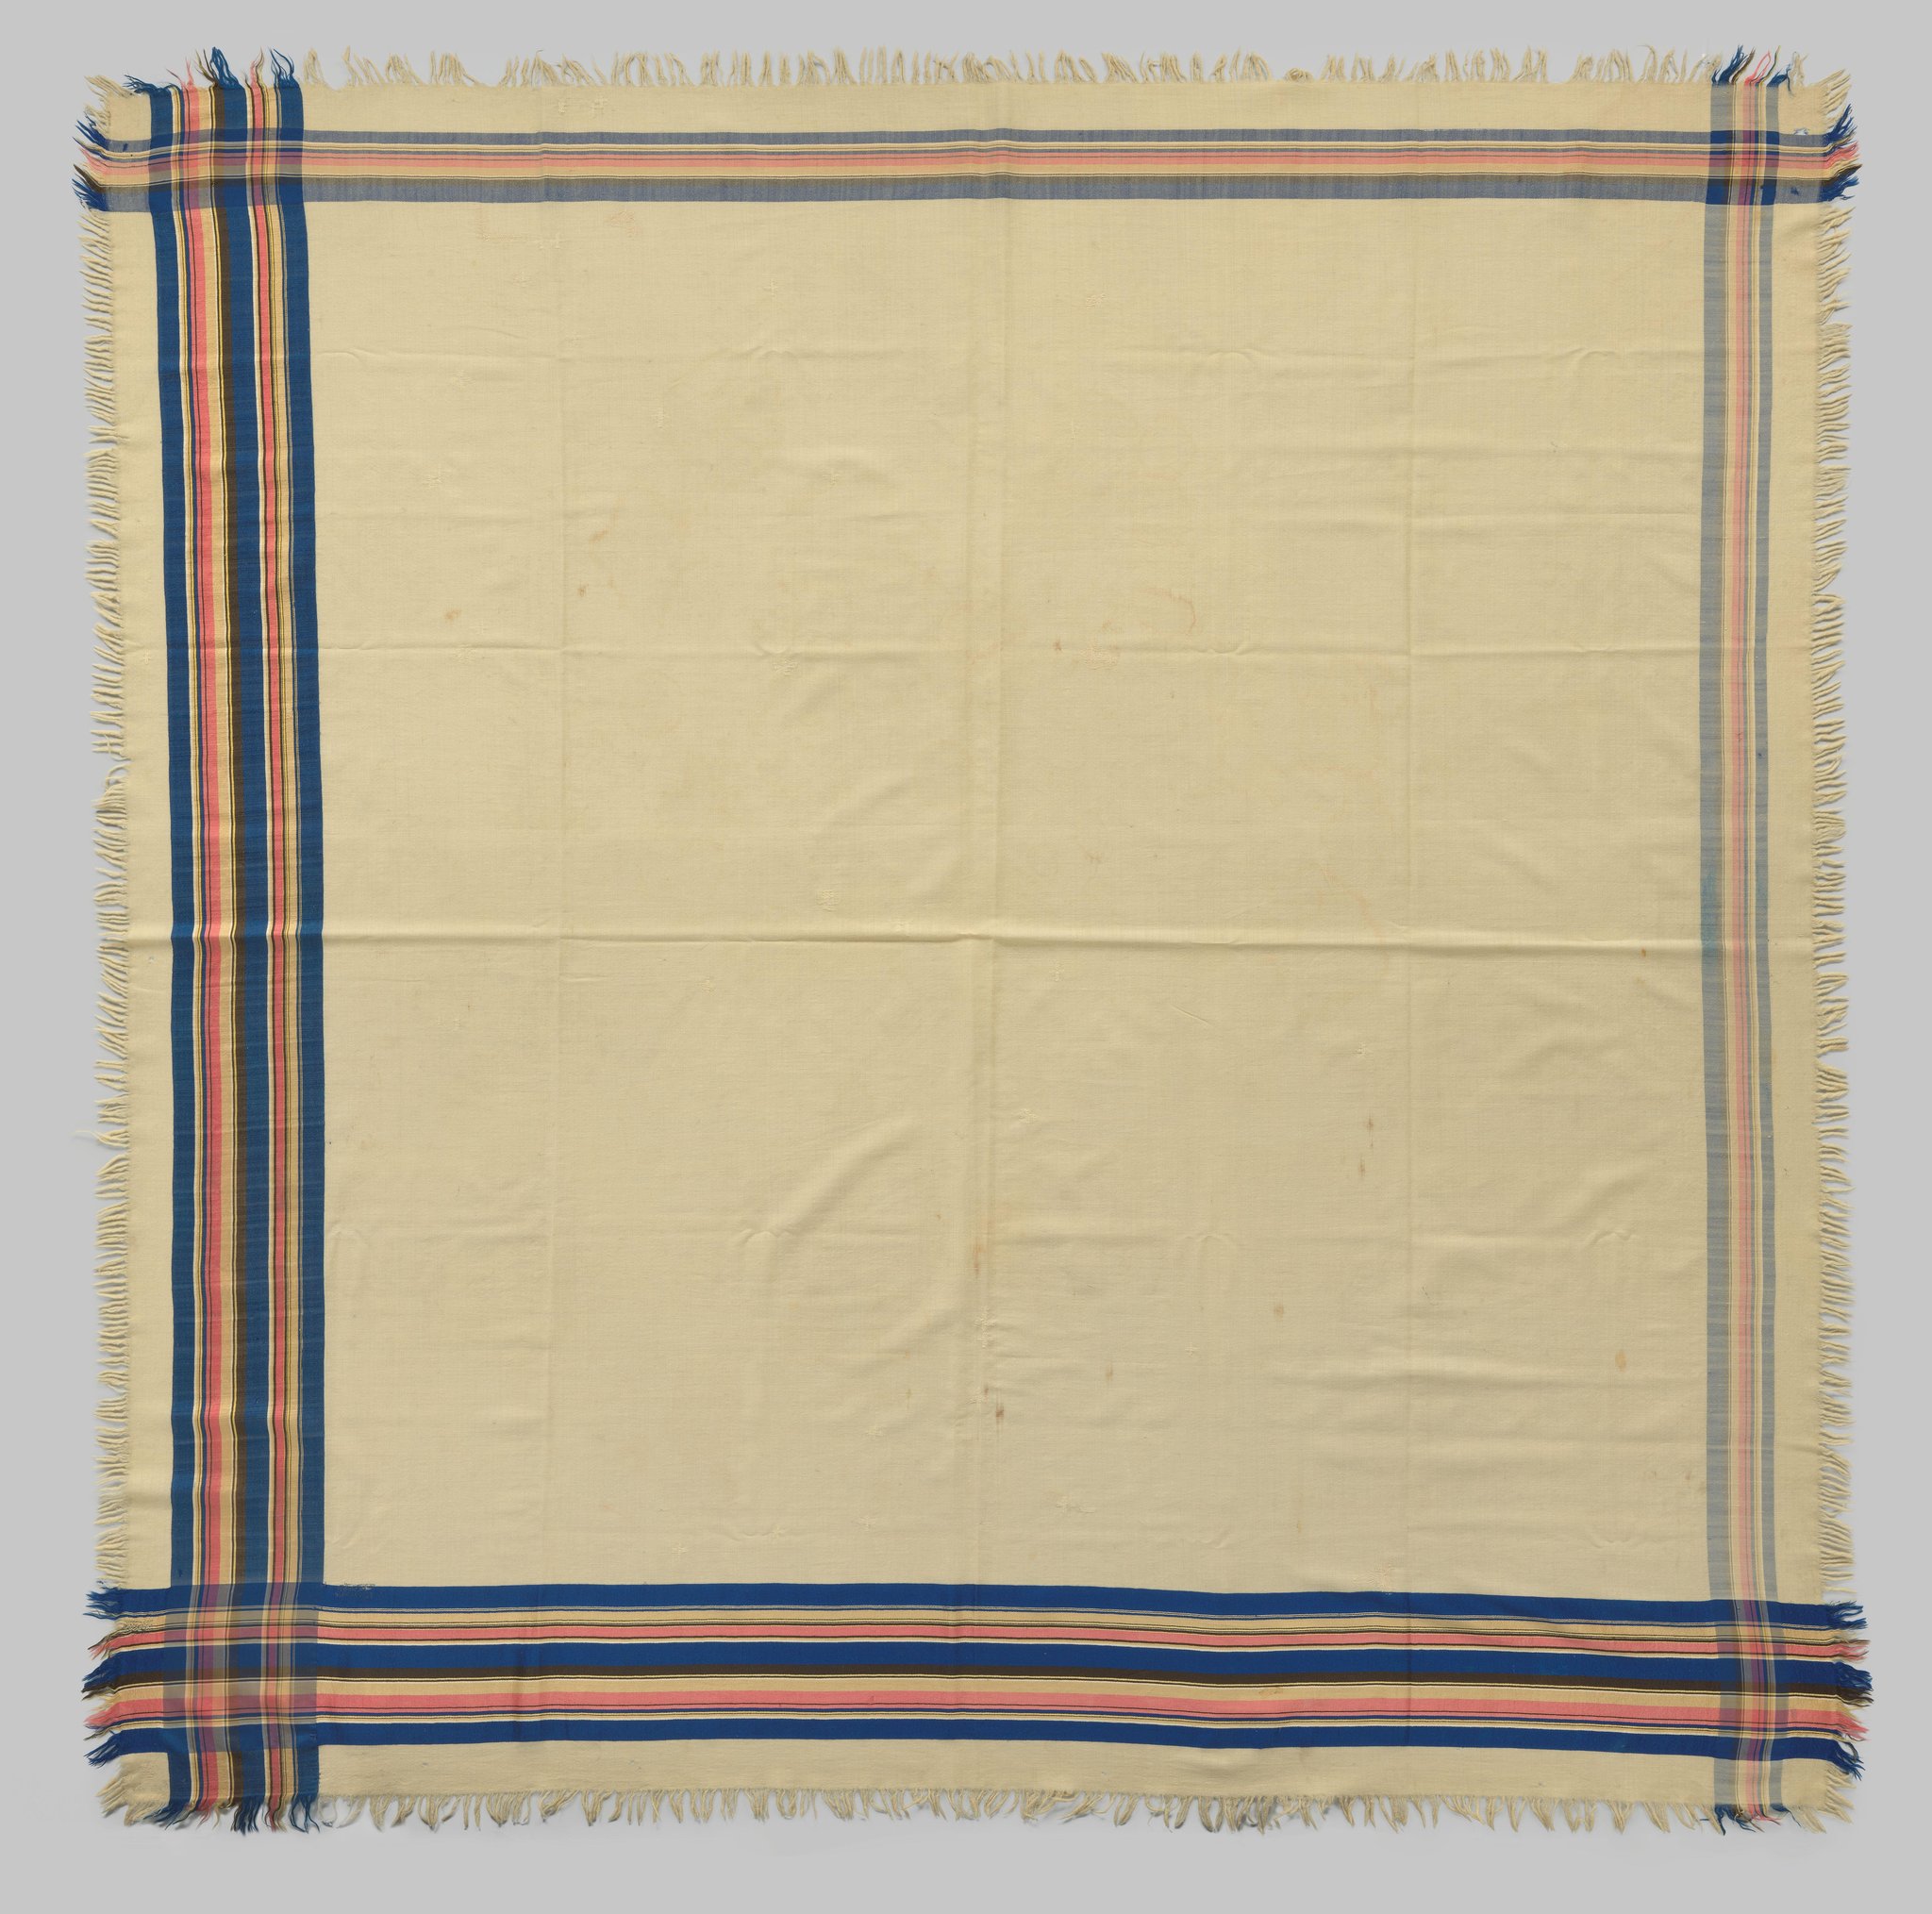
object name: scarf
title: Vierkante sjaal van naturelkleurige wol met tegen de kanten een ingeweven rand in blauw, roze, ecru en zwart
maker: Anonymous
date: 1840-1860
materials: silk, wool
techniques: weave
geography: western europe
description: Shawl van beige wol met kleurige zijden zanden, in ruitpatroon. De randen zijn per hoek aan de voor- en achterzijde in het vóórdecor geweven, waartuit blijkt dat het stuk in een driehoek gevouwen, met de punten iets boven elkaar, wordt gedragen.